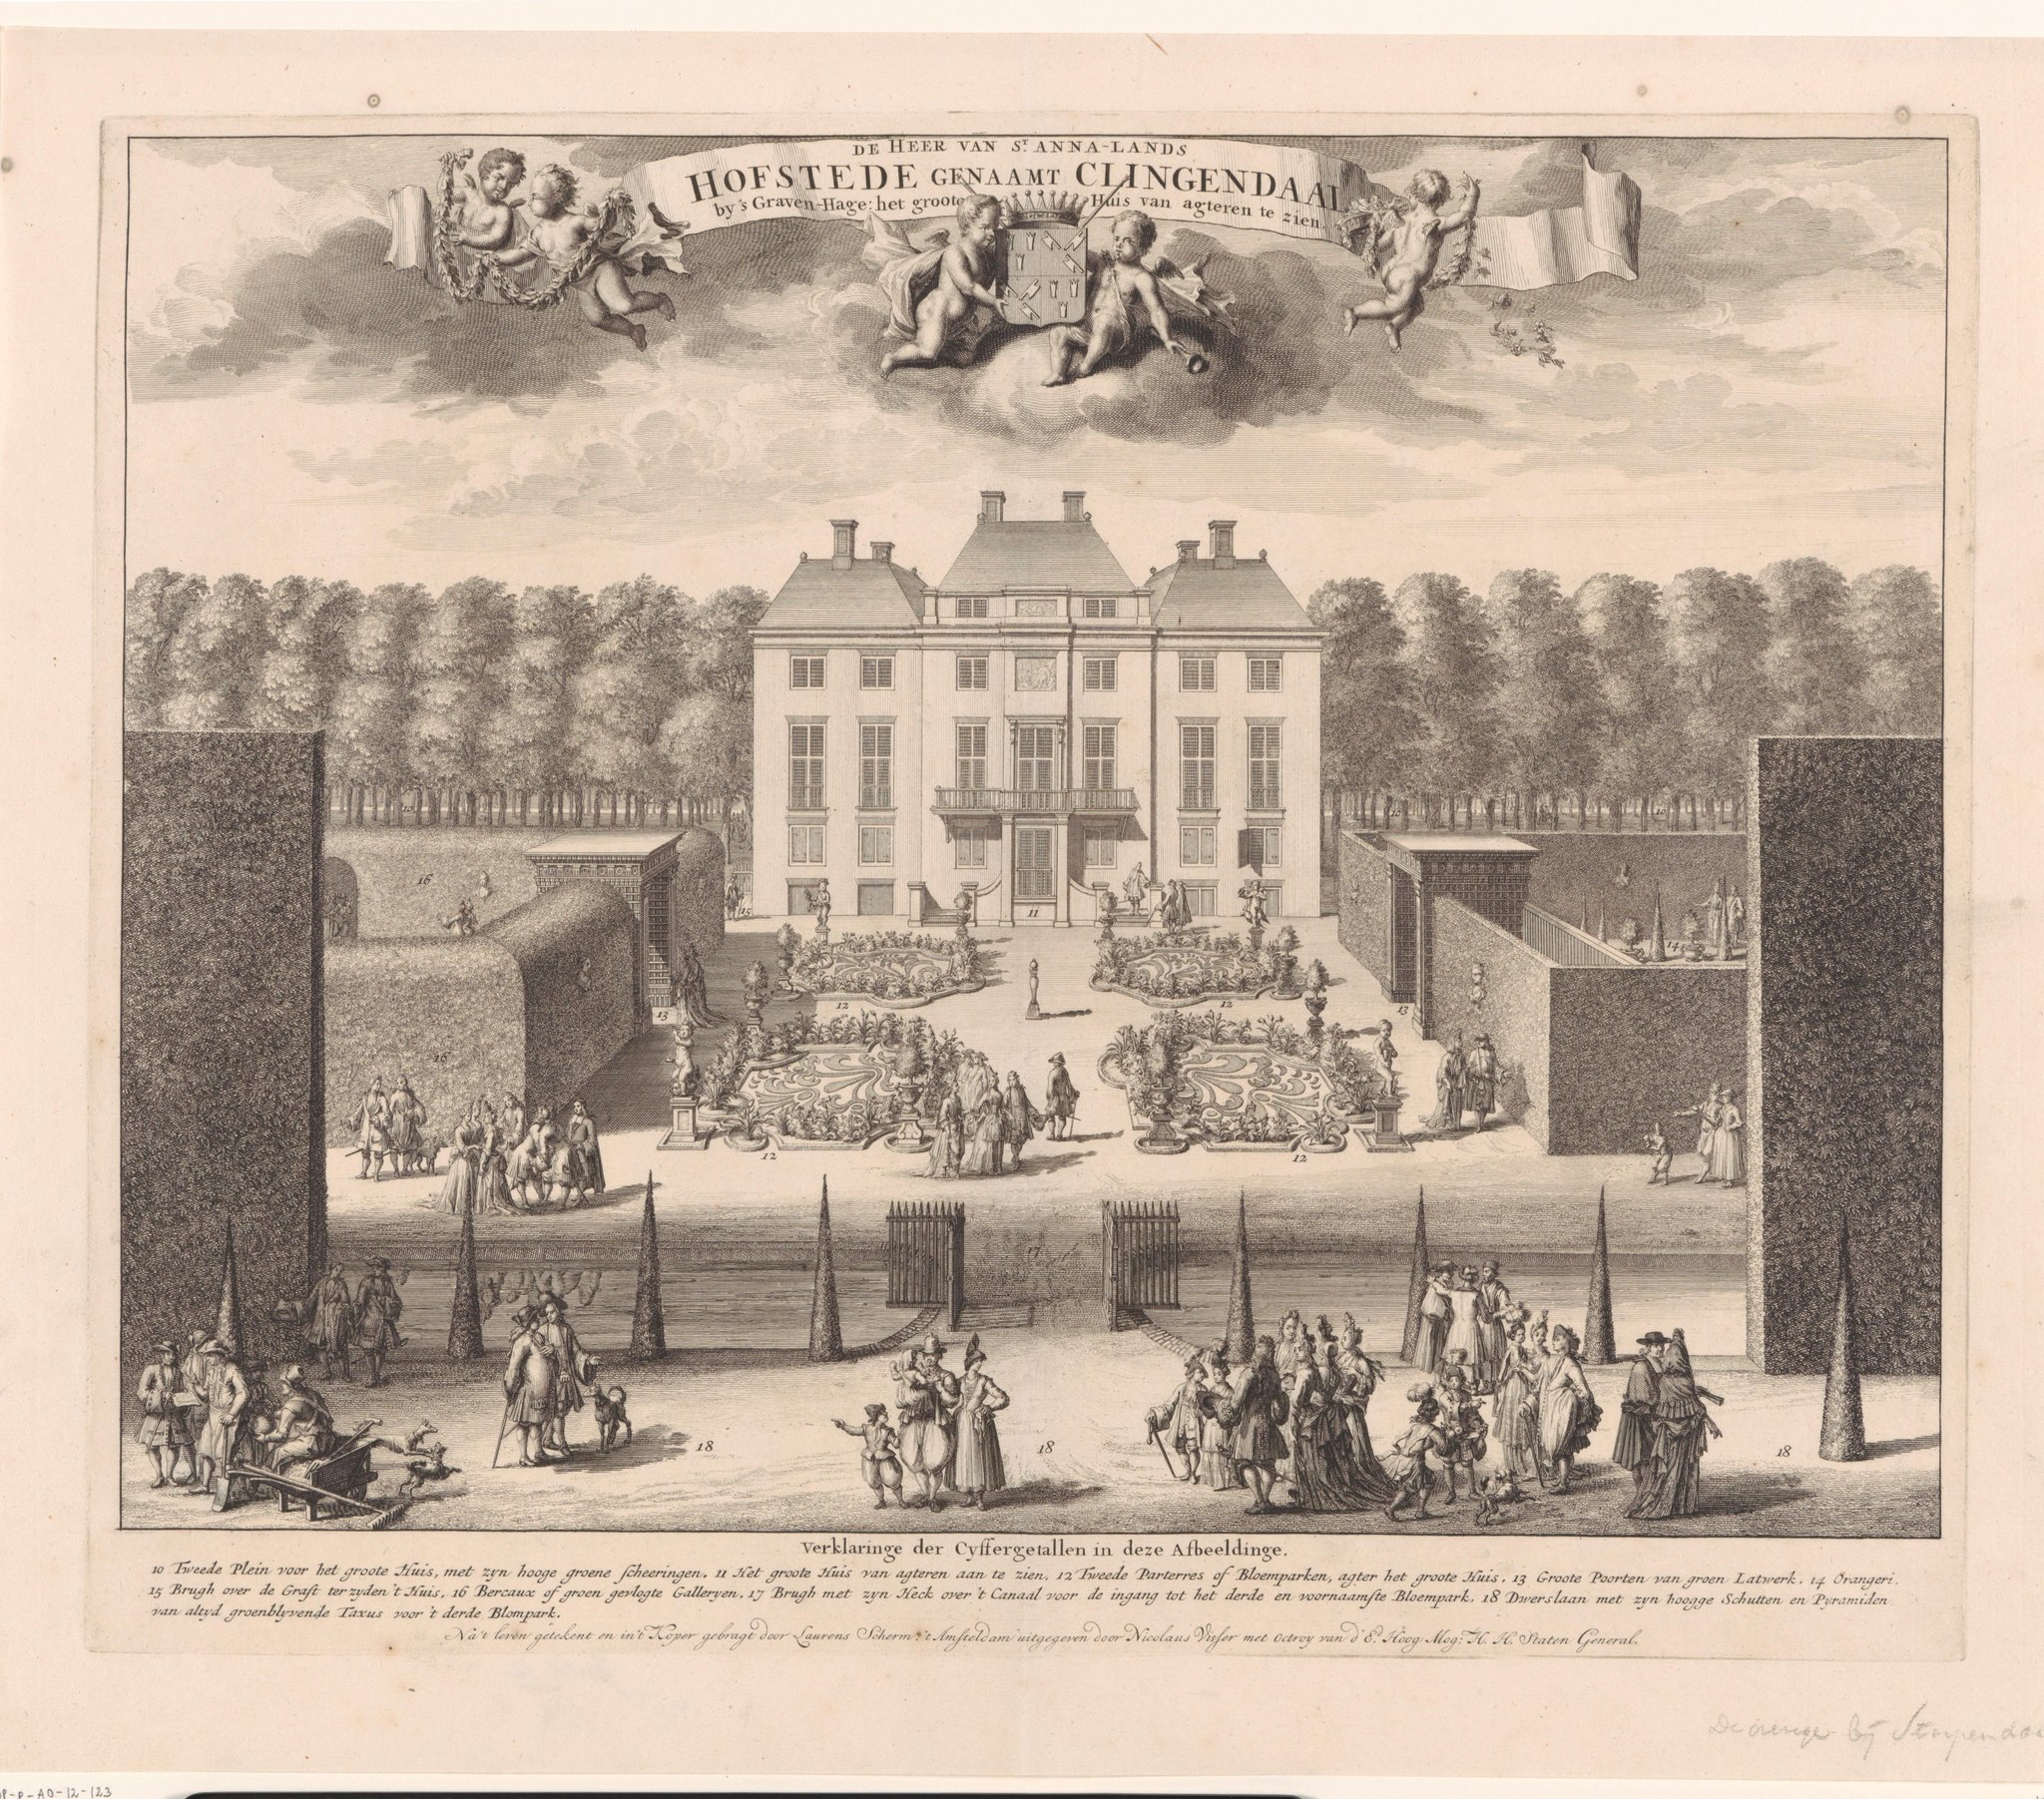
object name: print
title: Landgoed Clingendael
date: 1689-1709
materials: paper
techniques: engraving, etching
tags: french or architectonic garden; formal garden, country-house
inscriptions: collector's mark: Lugt 2228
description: Gezicht vanaf de tuin op Landgoed Clingendael, met op de voorgrond en in de tuin wandelende paren en gezinnen. Midden boven een door putti gedragen wimpel met de titel en een wapenschild.